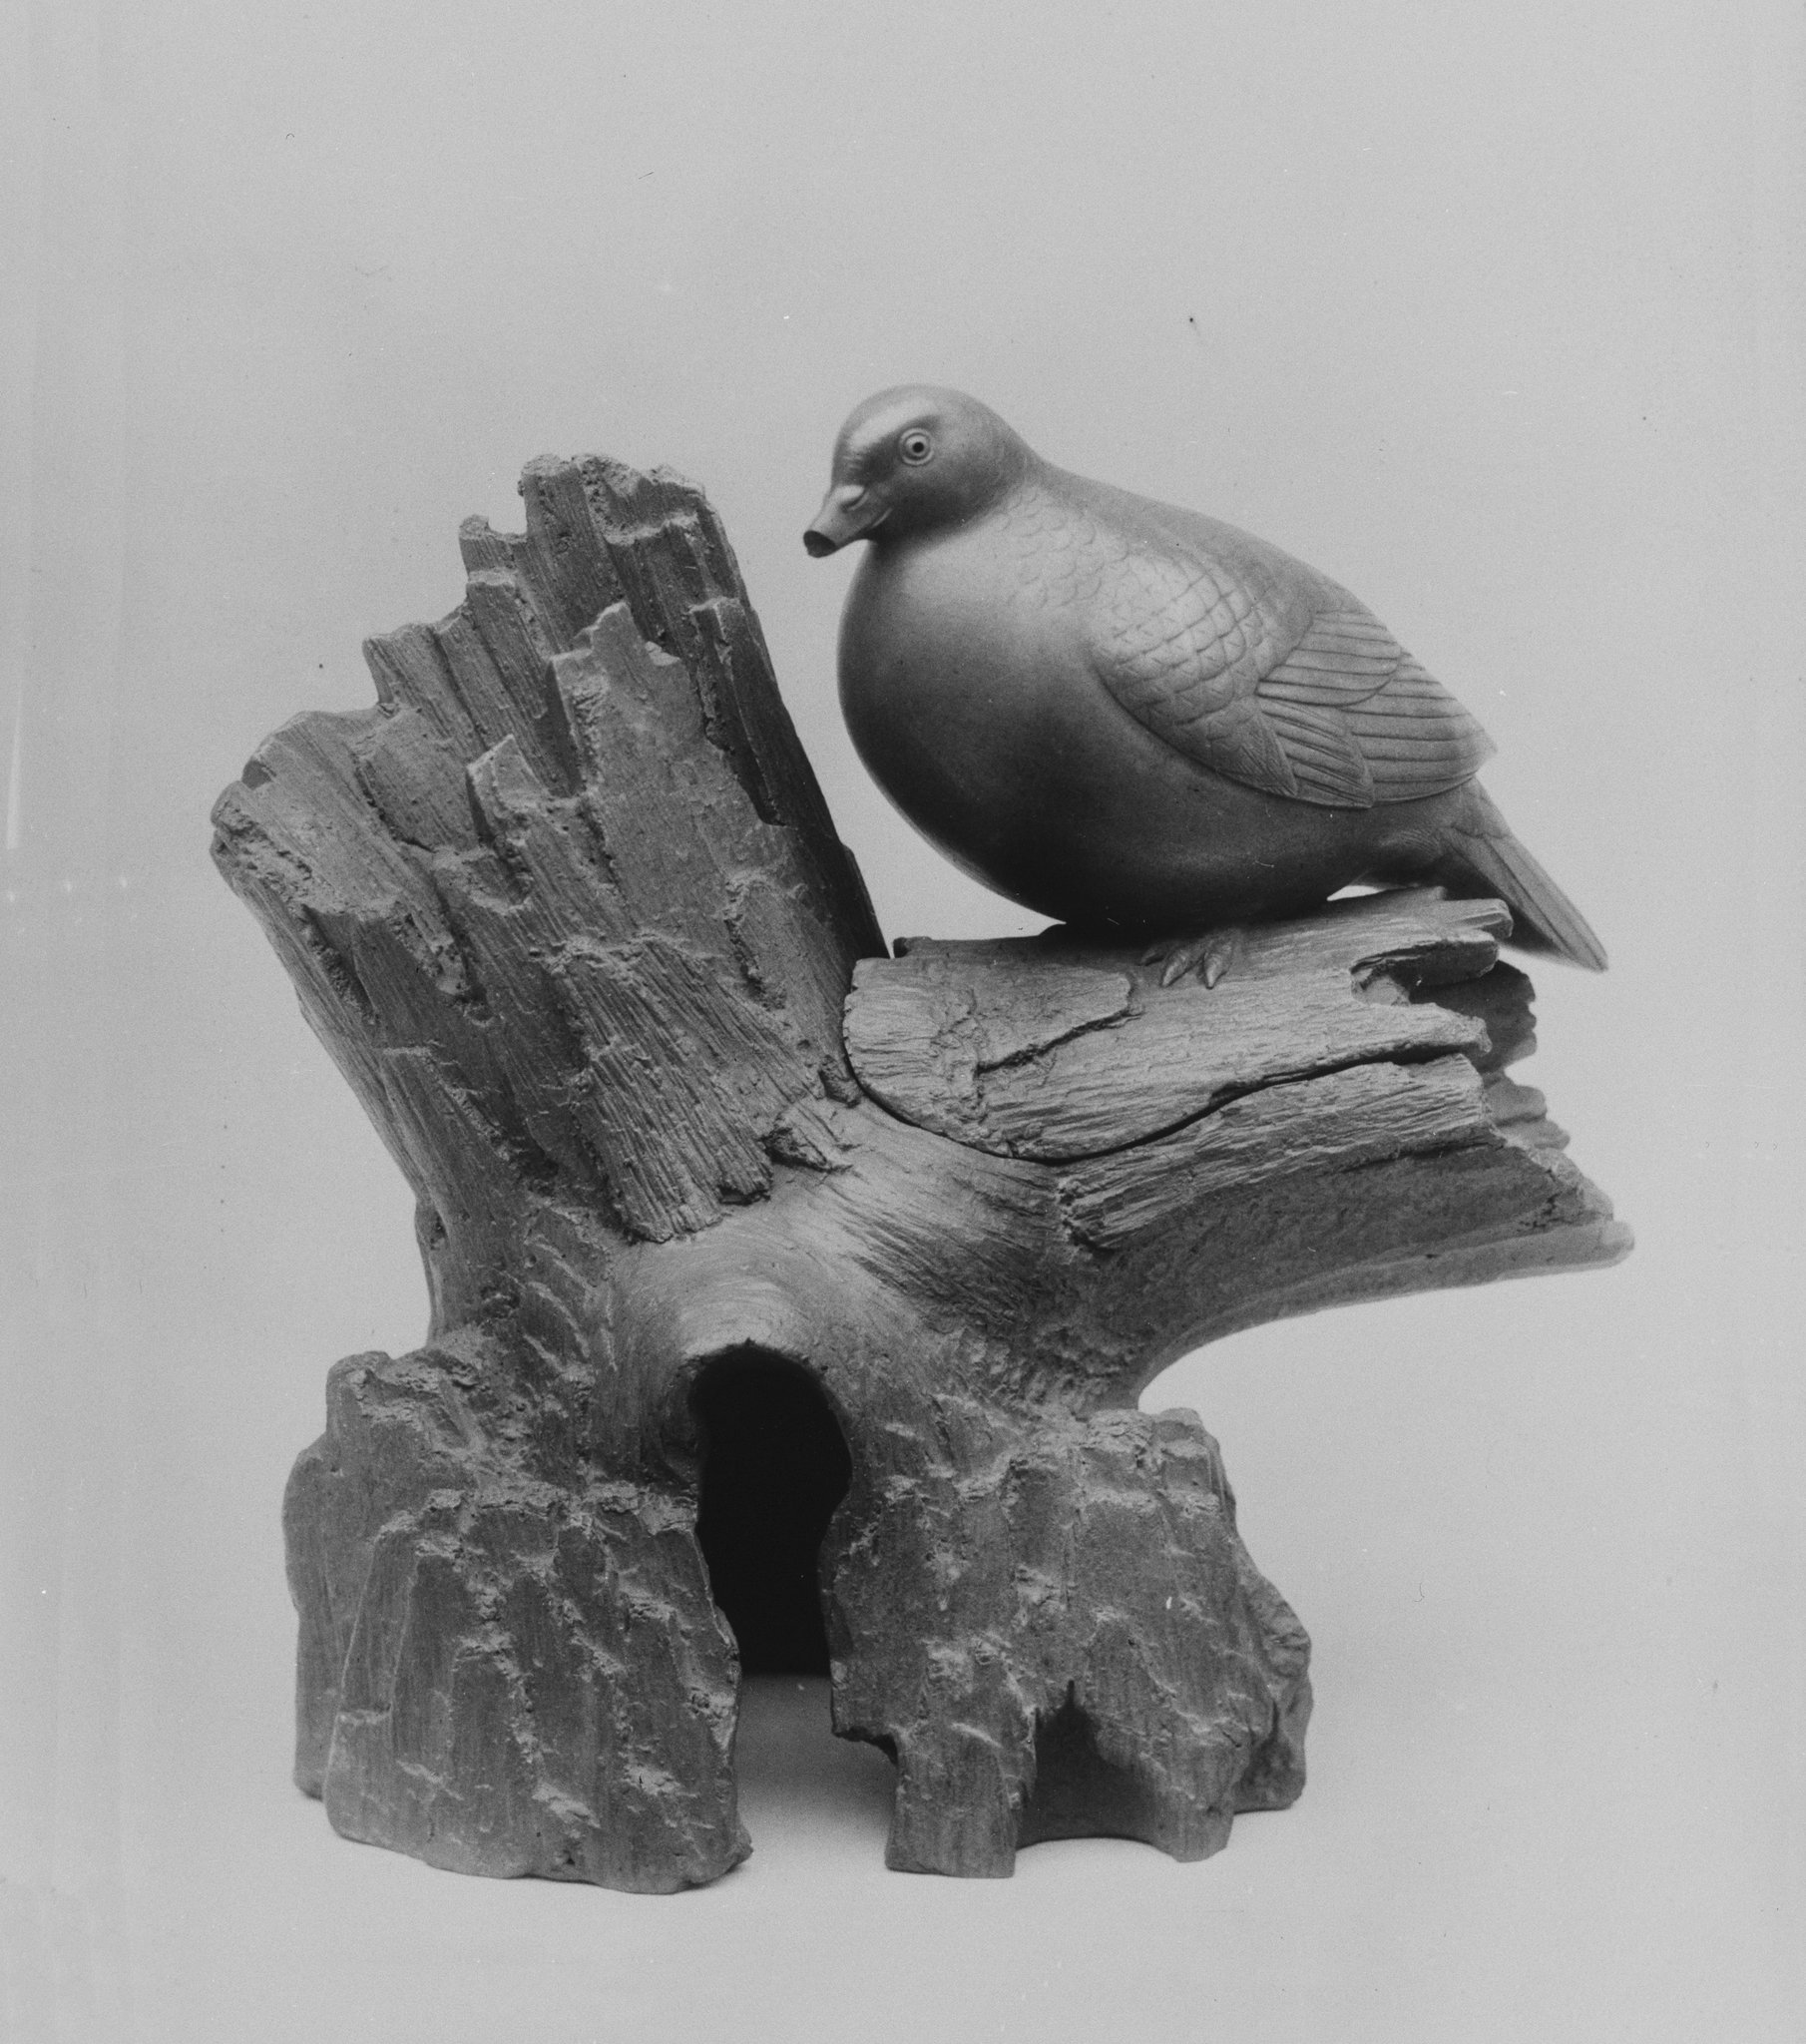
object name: figure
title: Pigeon on a Stump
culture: japanese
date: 1650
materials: glaze, stoneware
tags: pigeons